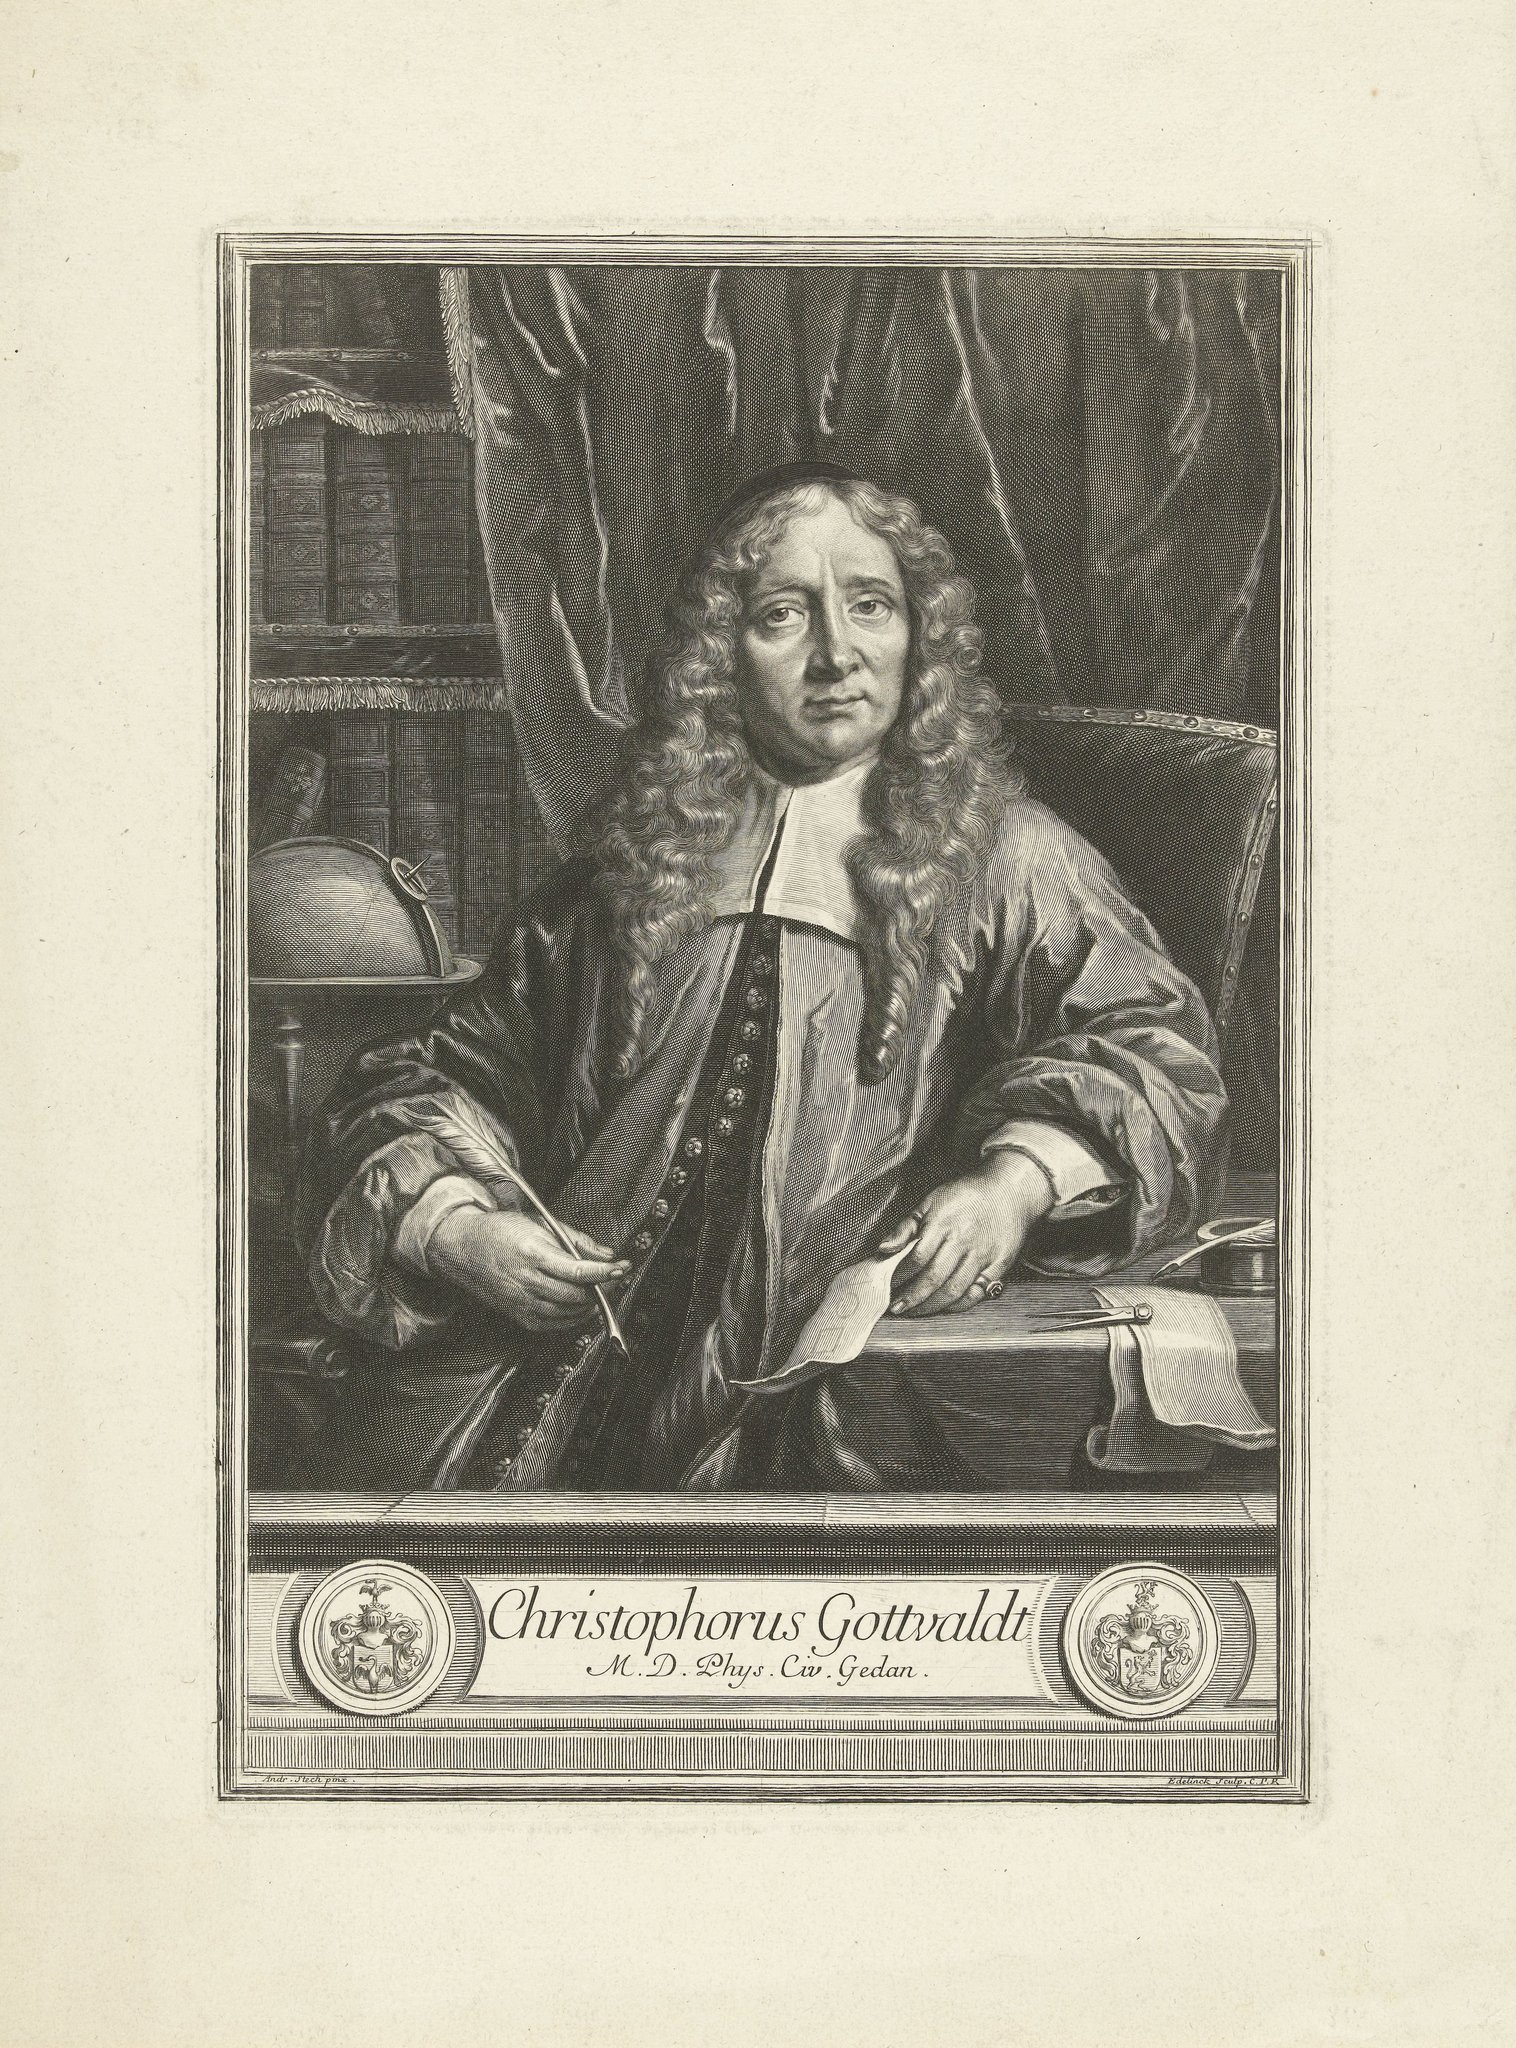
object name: print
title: Portret van Christophe Gottwaldt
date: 1666-1707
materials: paper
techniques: engraving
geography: france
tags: arts, christophe gottwaldt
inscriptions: collector's mark: Lugt 2228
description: De Duitse arts Christophe Gottwaldt (1636-1700), zittend aan tafel met ganzenveer in rechter en papier in linker hand. Op de achtergrond een globe en een boekenkast. Op de voorgrond een console met twee wapens.